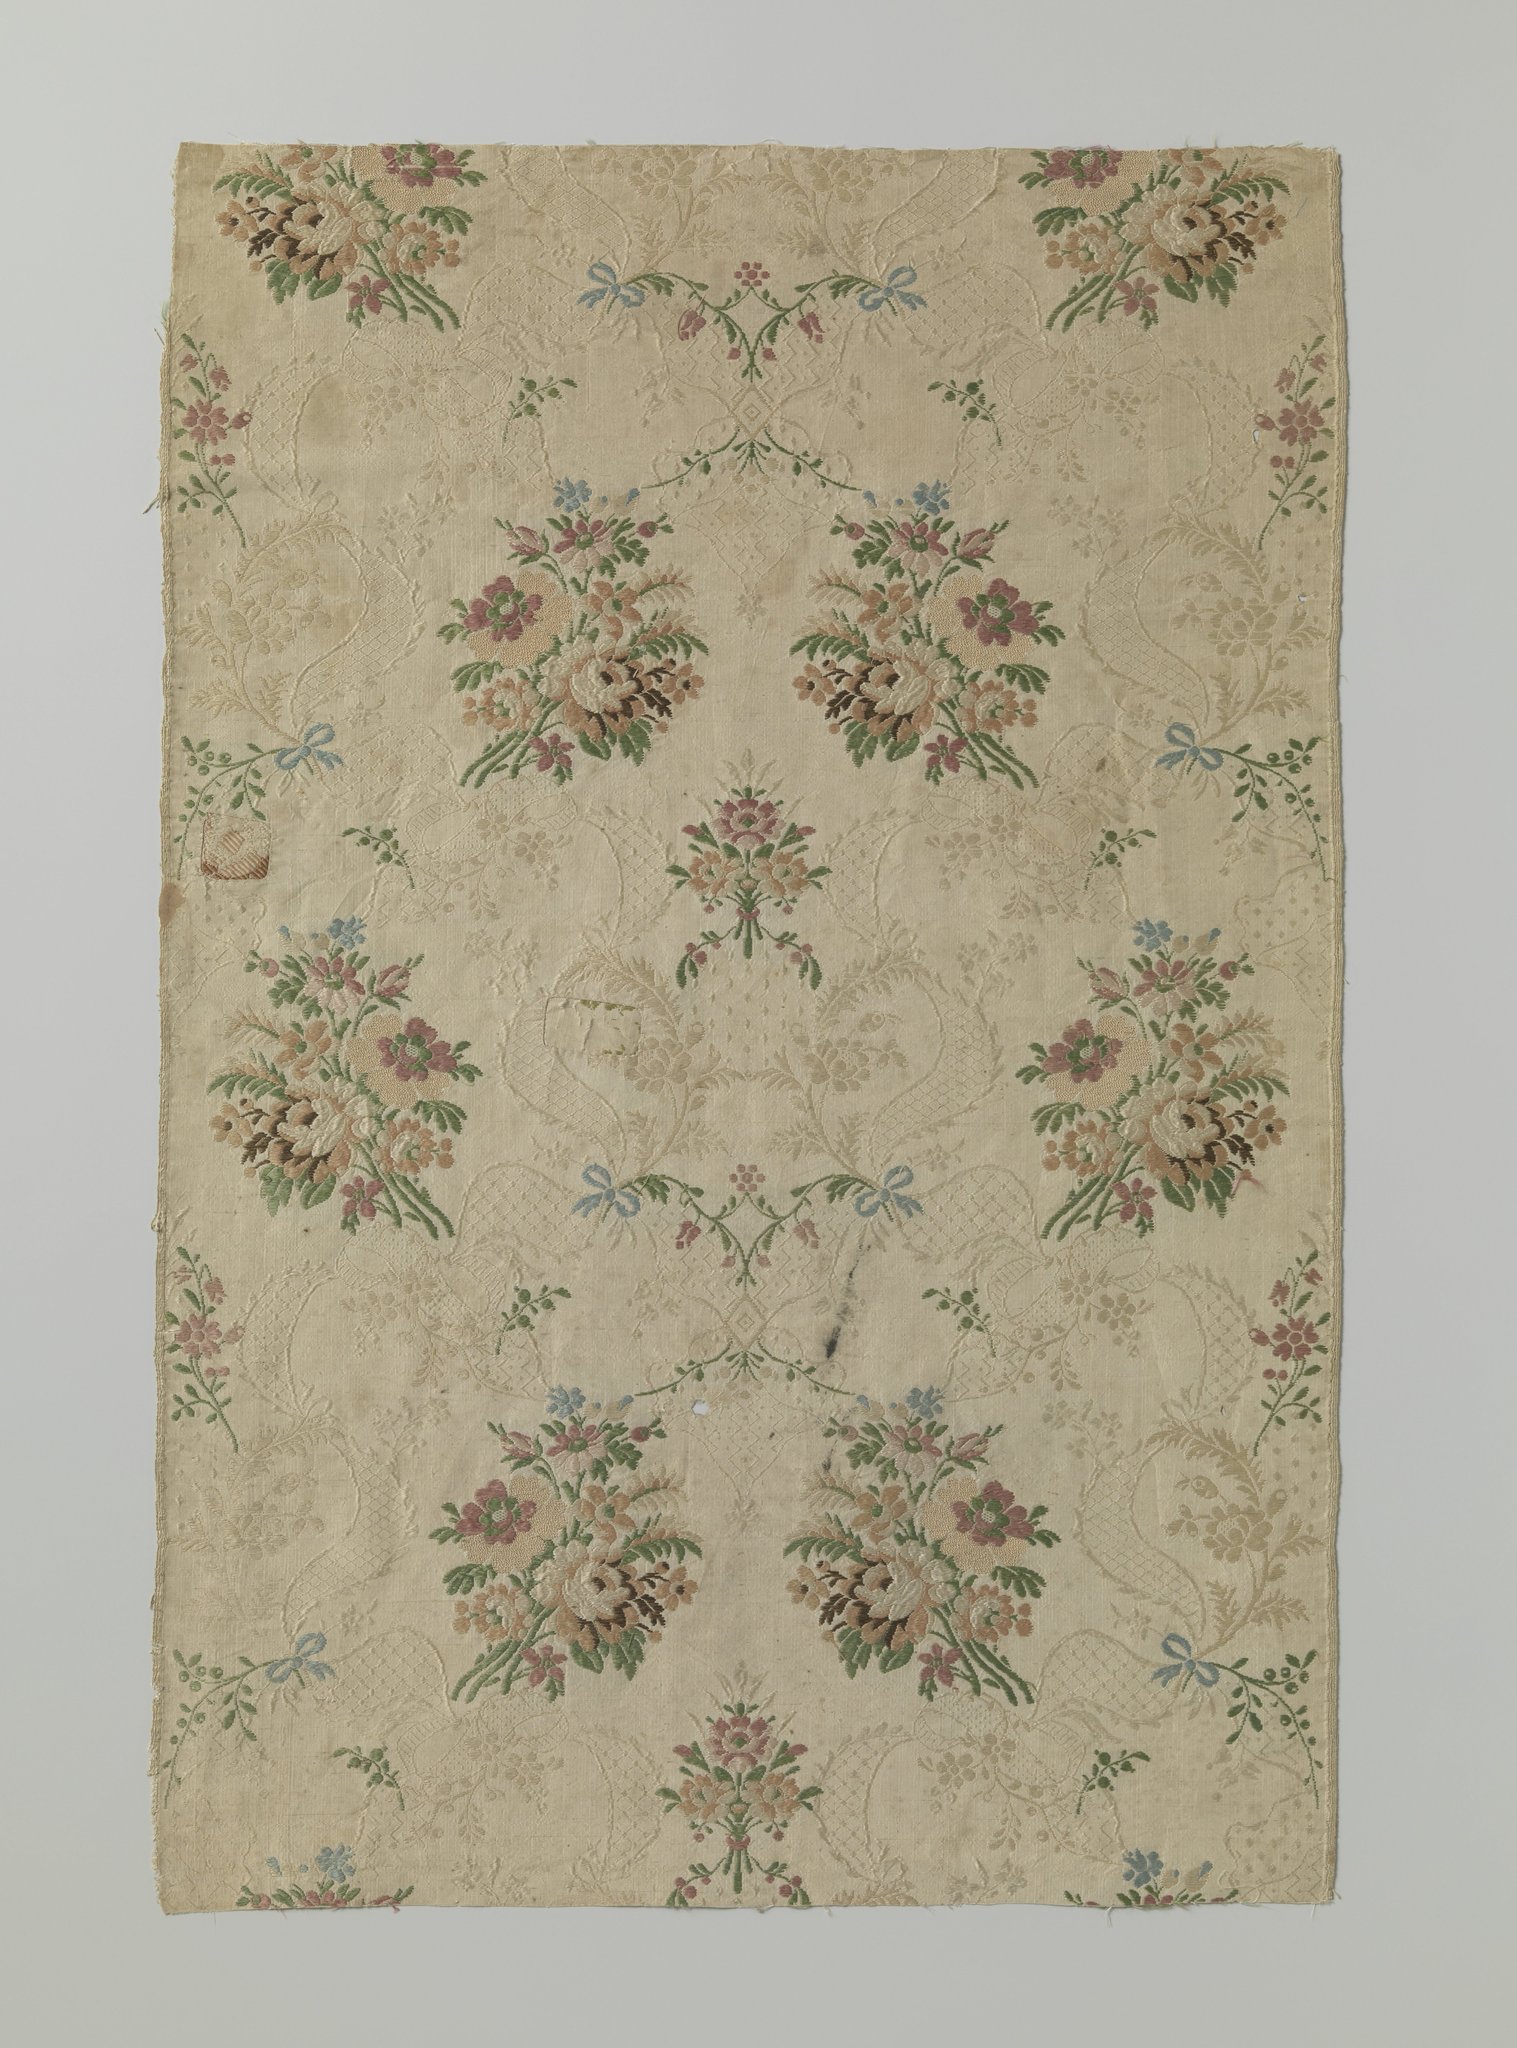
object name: fragment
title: Fragment veelkleurige gebrocheerde zijde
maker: Anonymous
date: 1750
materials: silk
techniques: brocade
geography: netherlands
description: Fragment veelkleurig zijdeweefsel. Een witte grond heeft een patroon van kantslingers die medaillons vormen waarbinnen bloemboeketten.